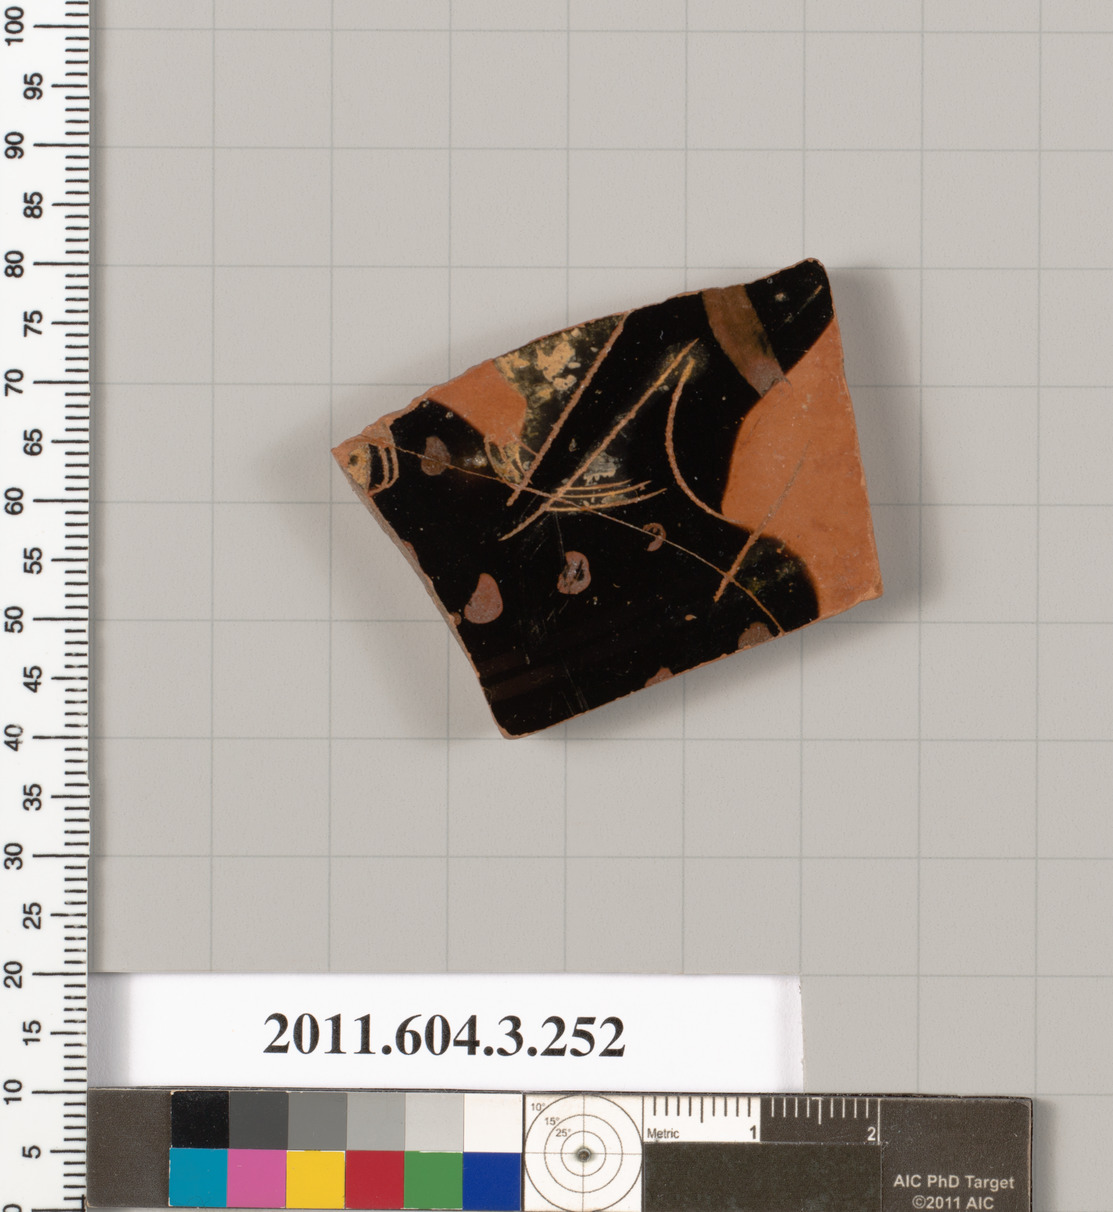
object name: neck amphora fragment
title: Terracotta fragment of a neck-amphora (jar)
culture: greek, attic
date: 510-500 BCE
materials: terracotta